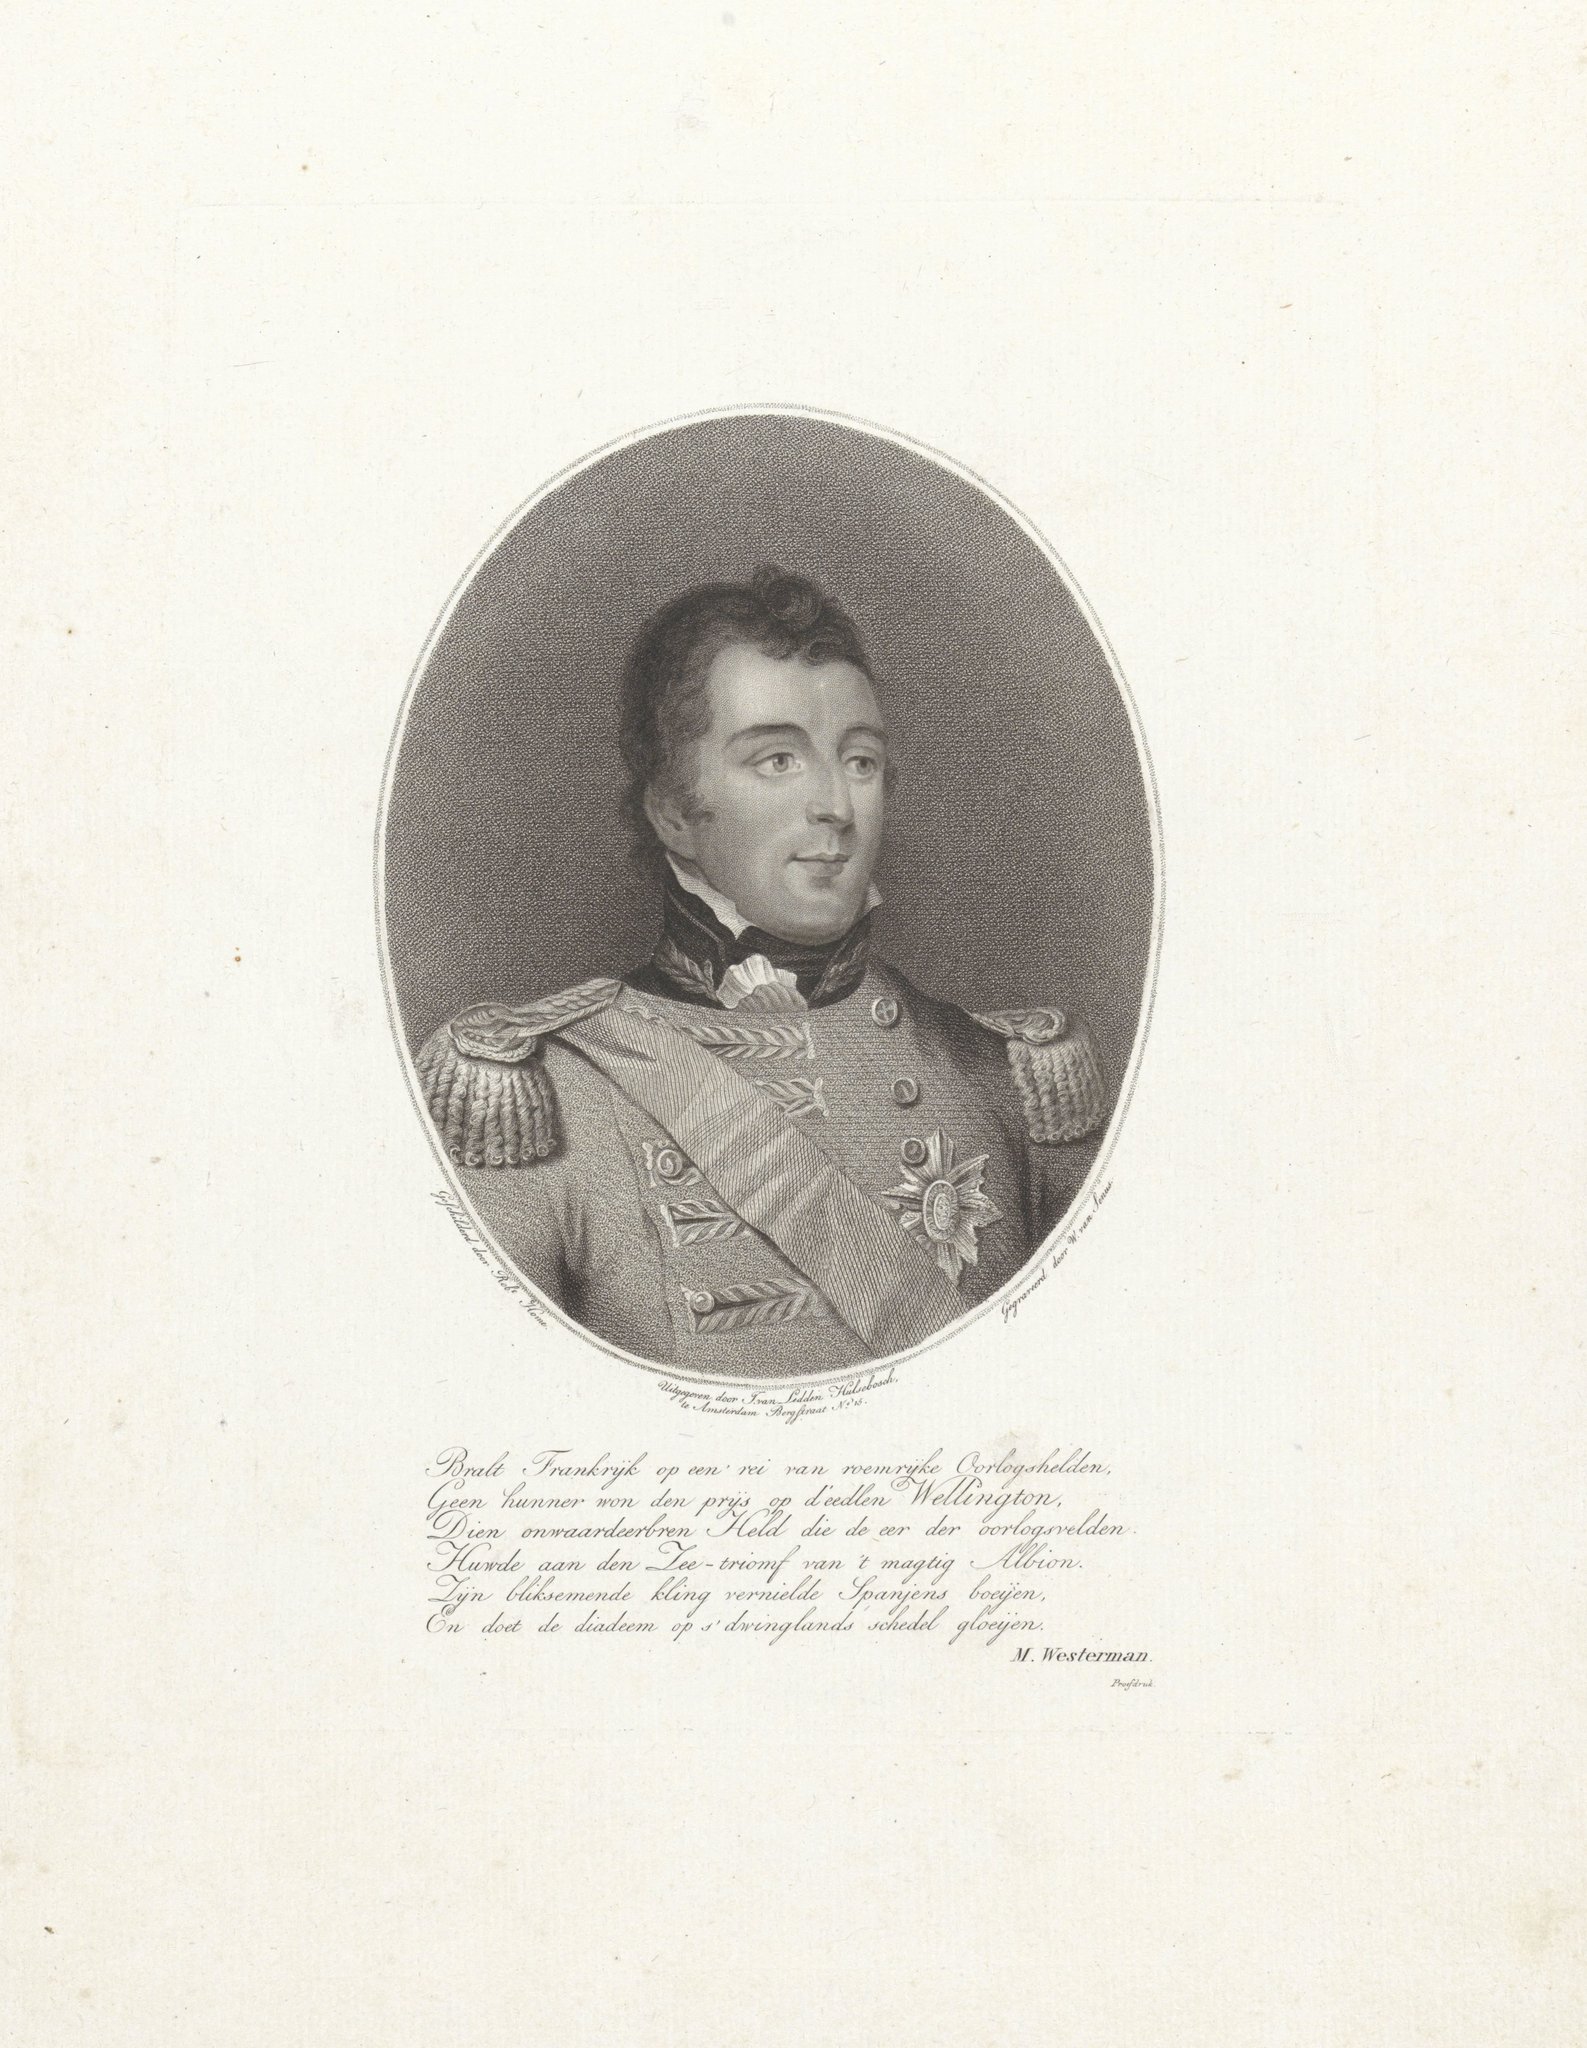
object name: print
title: Portret van Arthur Wellesley, markies van Wellington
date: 1808-1851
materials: paper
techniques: engraving, etching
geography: amsterdam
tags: arthur wellesley of wellington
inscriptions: collector's mark: Lugt 2228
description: Portret van Arthur Wellesley, markies van Wellington, Iers militair leider en later staatsman van het Verenigd Koninkrijk van Groot-Brittannië en Ierland.